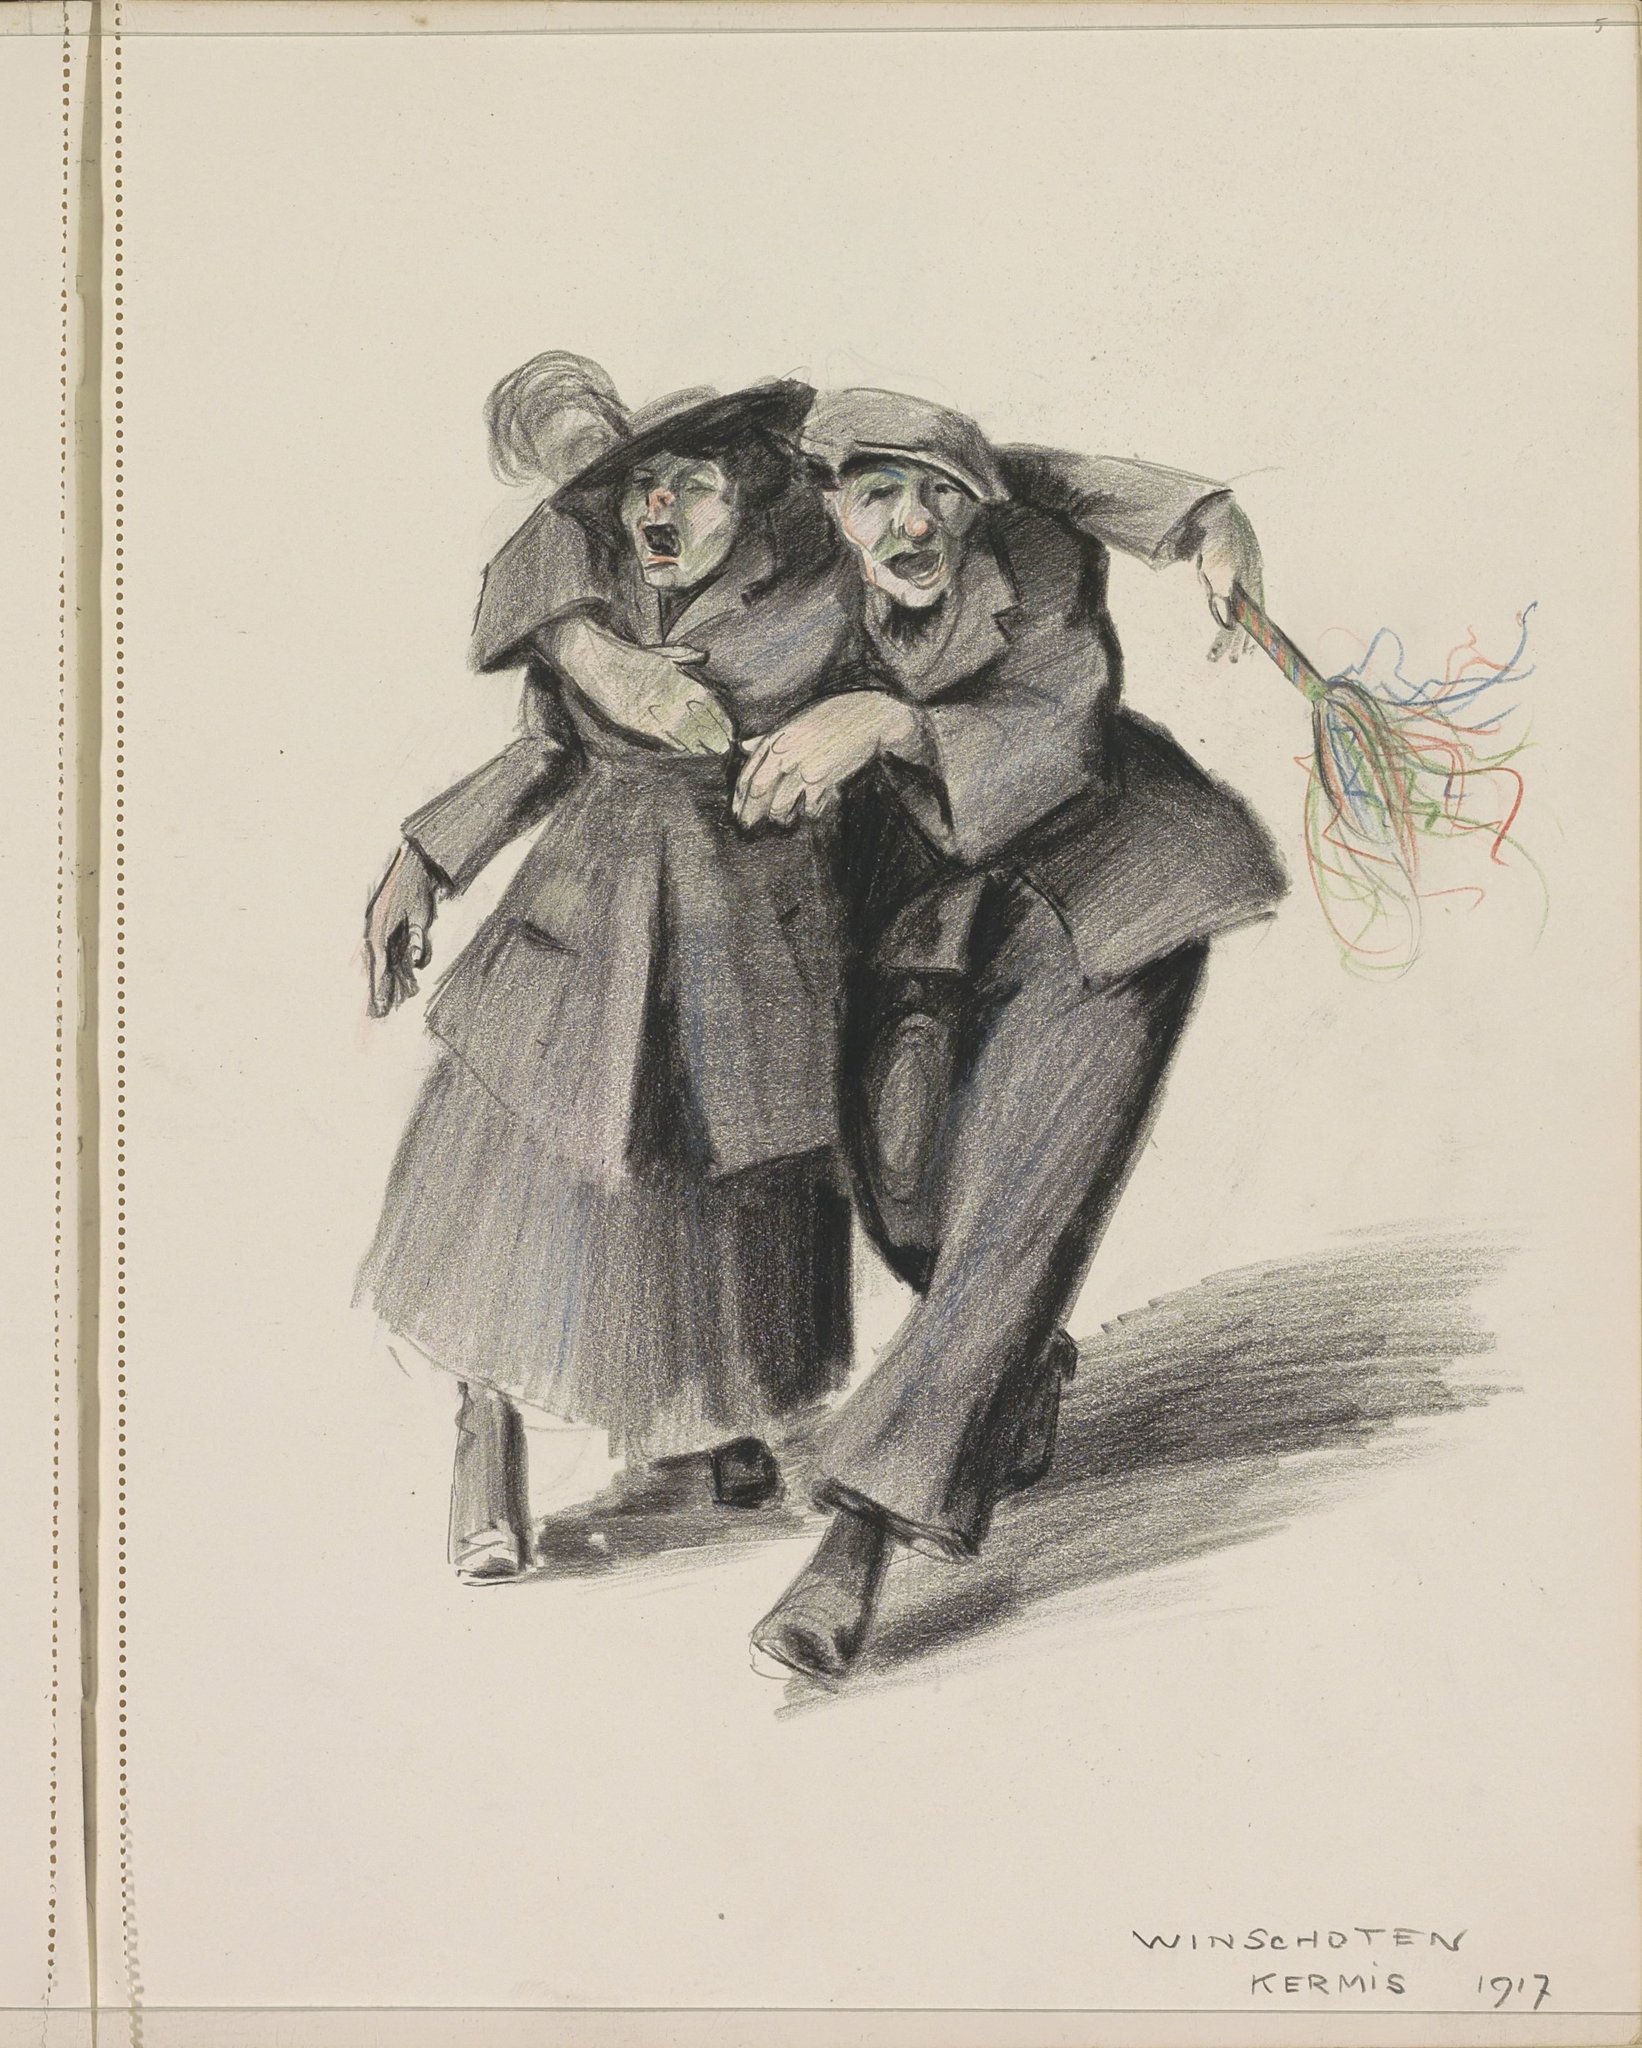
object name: sketchbook leaf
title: Dronken paar op de Kermis van Winschoten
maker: otto verhagen (i)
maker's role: draughtsman, print maker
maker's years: 1885-1951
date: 1917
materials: chalk, paper, pencil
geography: winschoten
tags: drunkenness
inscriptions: date and inscription: ‘WINSCHOTEN/ KERMIS 1917’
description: De man en vrouw hebben de armen over elkaars schouders geslagen en steunen op elkaar bij het lopen. Beiden hebben de mond open. De vrouw draagt een staf met veren of draden aan het uiteinde in haar linkerhand. Pagina 5 uit een schetsboek met 28 bladen.